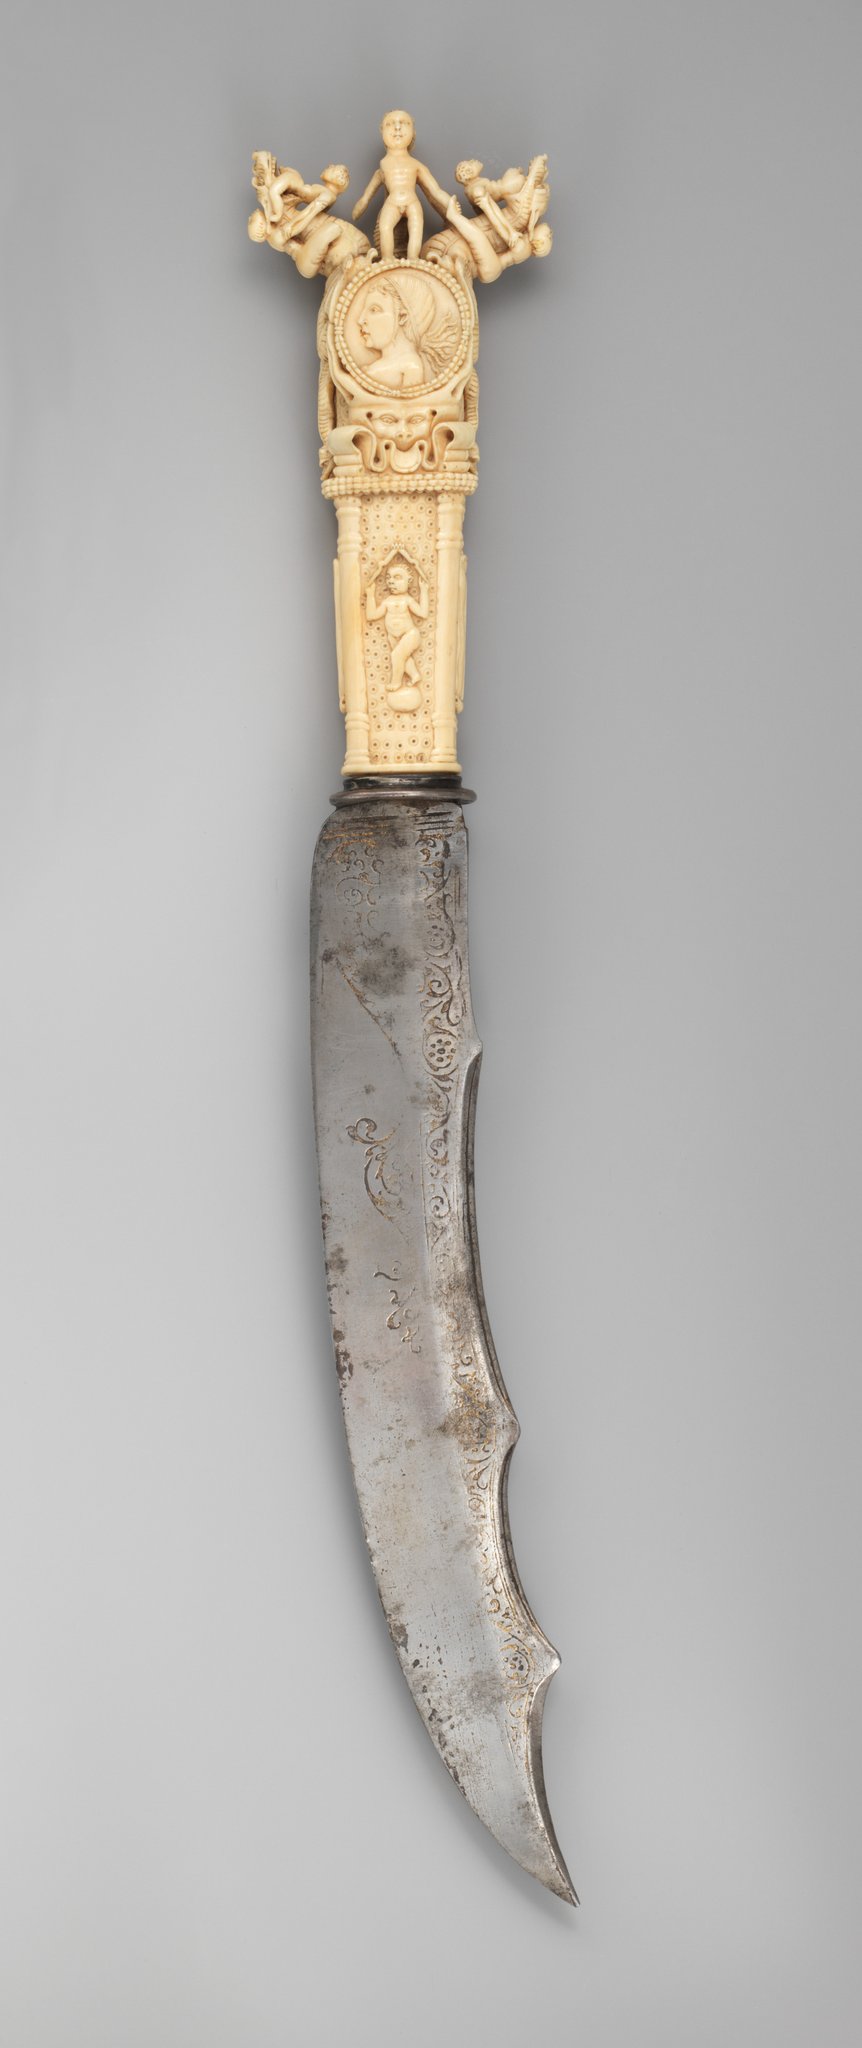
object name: knife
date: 1501-1600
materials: ivory, steel